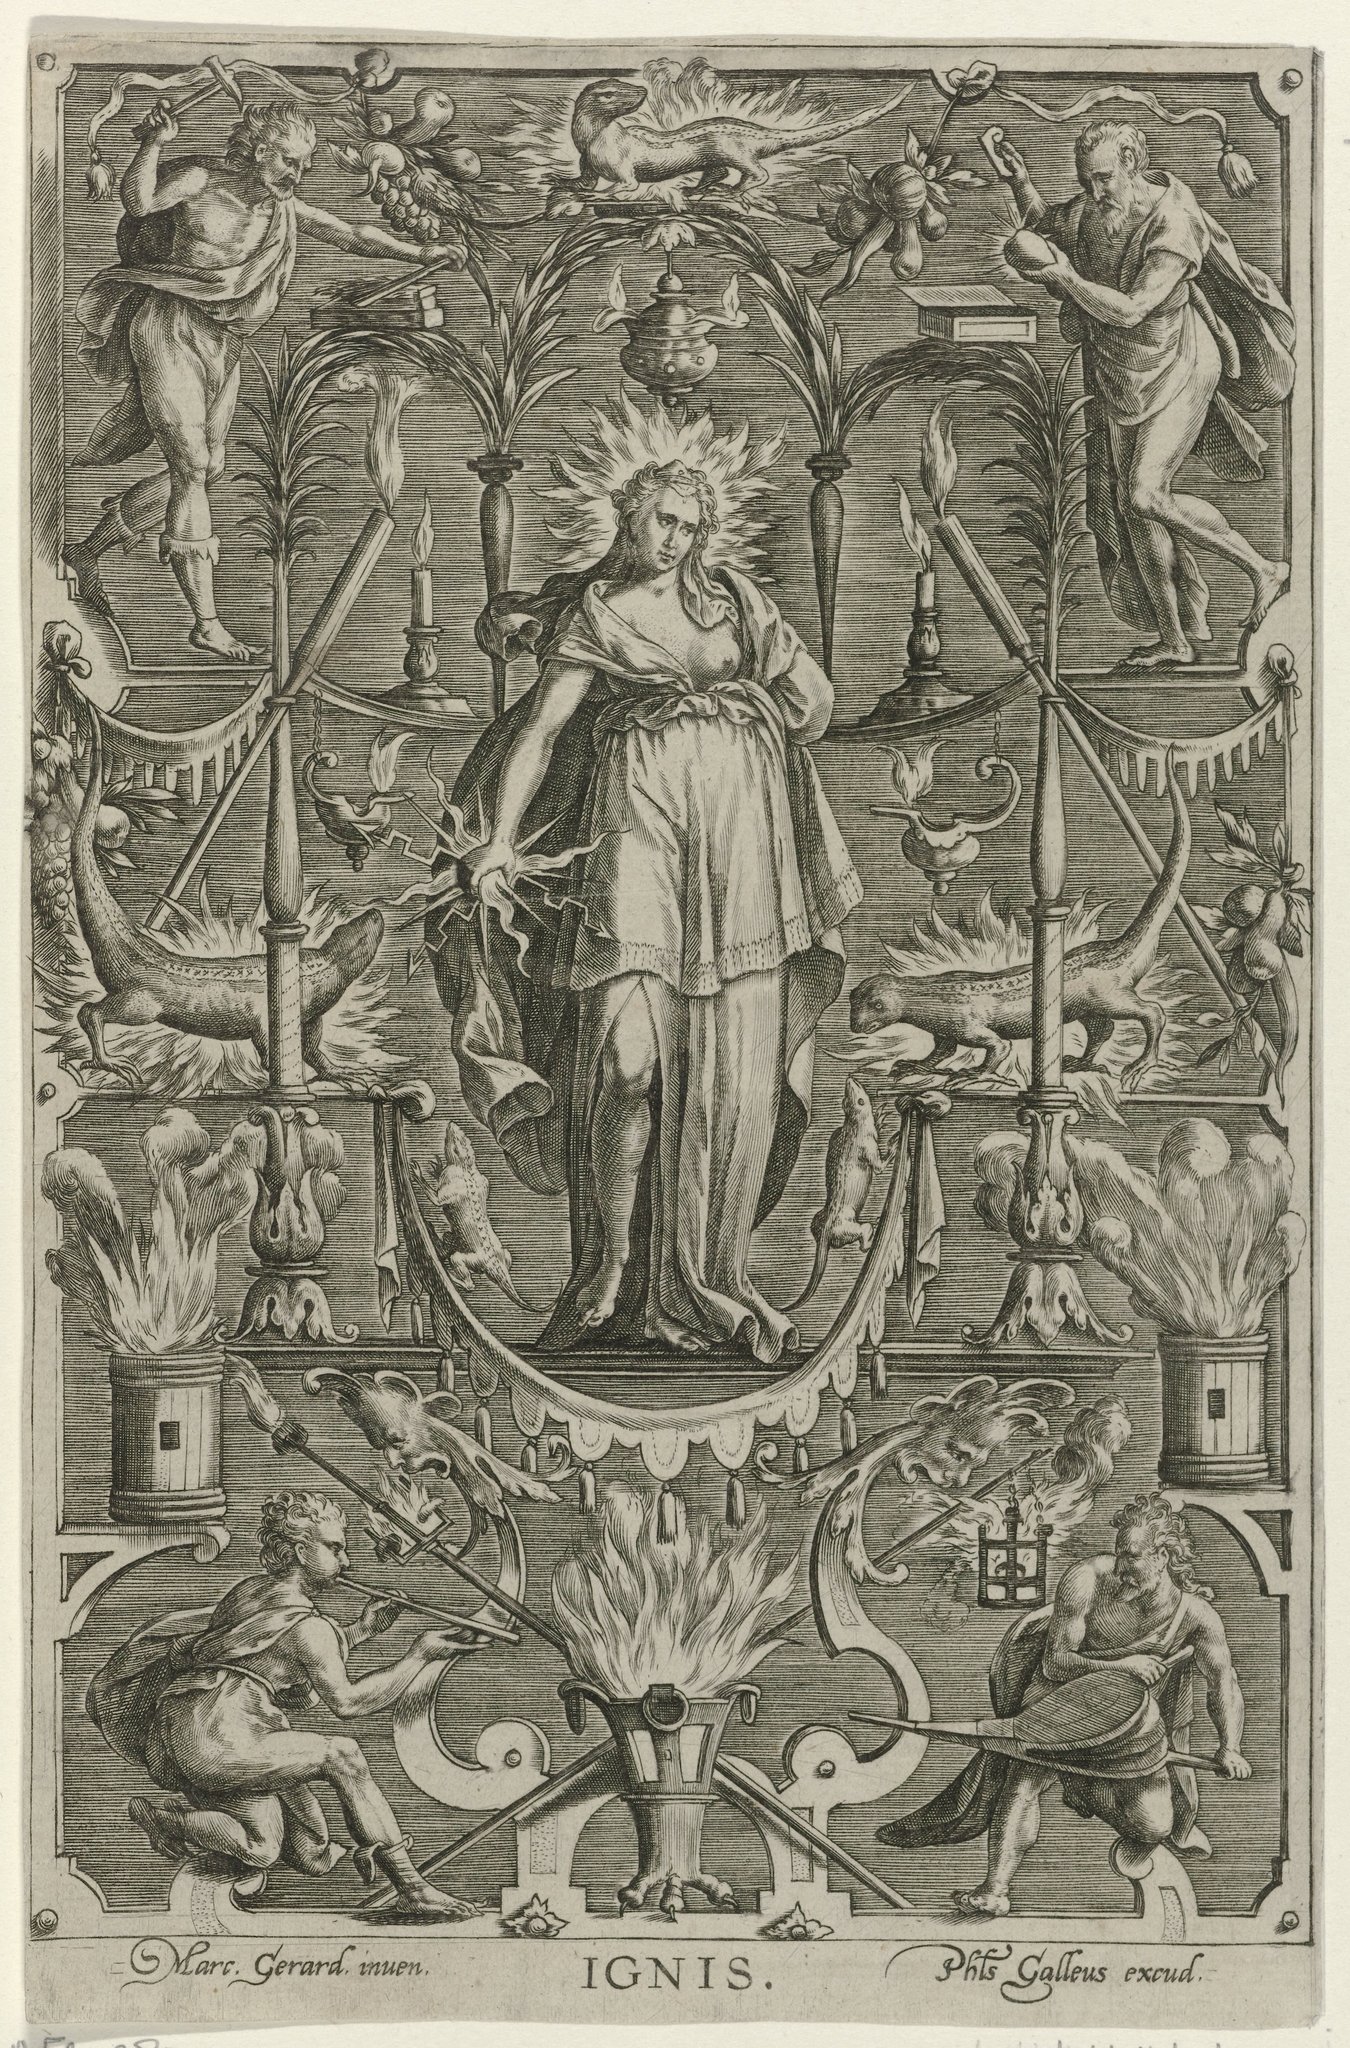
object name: print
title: Ignis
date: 1547-1622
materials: paper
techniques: engraving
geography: bruges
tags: ornament ~ arabesque, fire (one of the four elements)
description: De personificatie van Vuur, omringd door ornamentele versieringen. Ze heeft een bliksemstaf in haar hand en wordt geflankeerd door vuursalamanders. In de vier hoeken van de prent vier ambachtslieden die met vuur werken. De prent is deel van een reeks over de vier elementen.